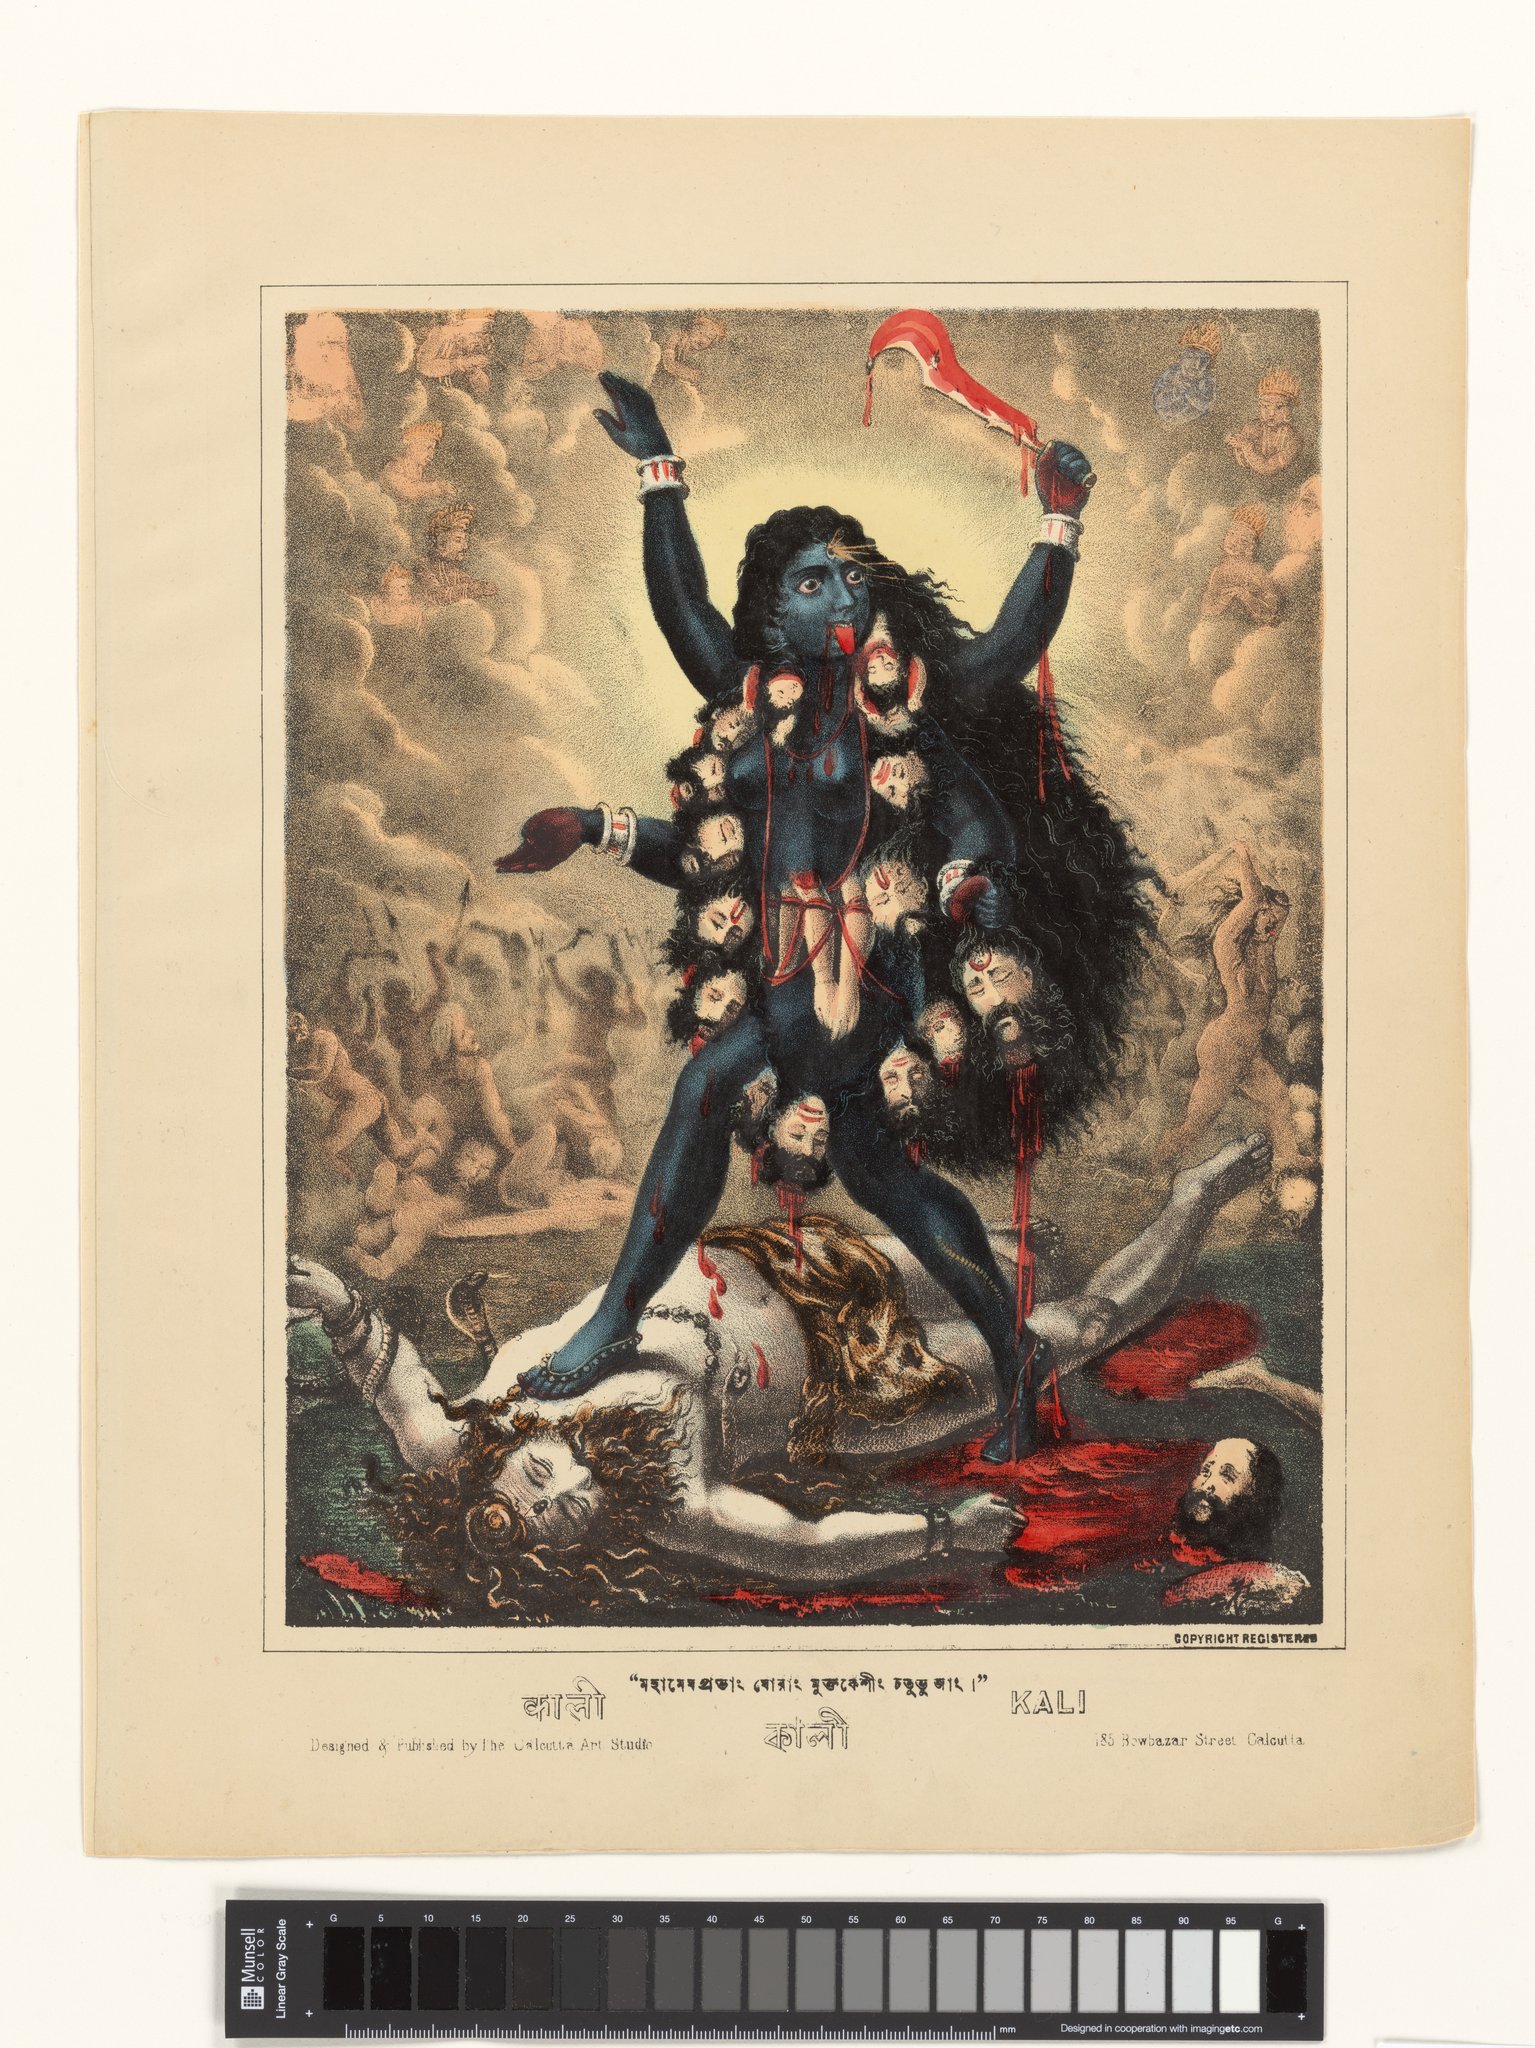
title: Goddess Kali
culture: west bengali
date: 1879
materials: glaze, watercolor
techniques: hand coloring, lithograph, printing